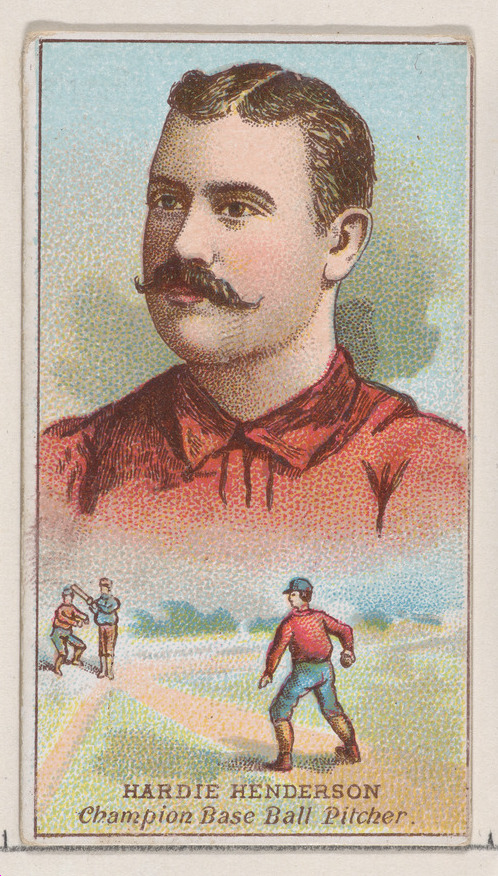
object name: print, baseball card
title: Hardie Henderson, Champion Baseball Pitcher, from the Champions of Games and Sports series (N184, Type 2) issued by W.S. Kimball & Co.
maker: w.s. kimball & co.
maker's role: publisher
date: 1887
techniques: color lithograph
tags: men,baseball,athletes